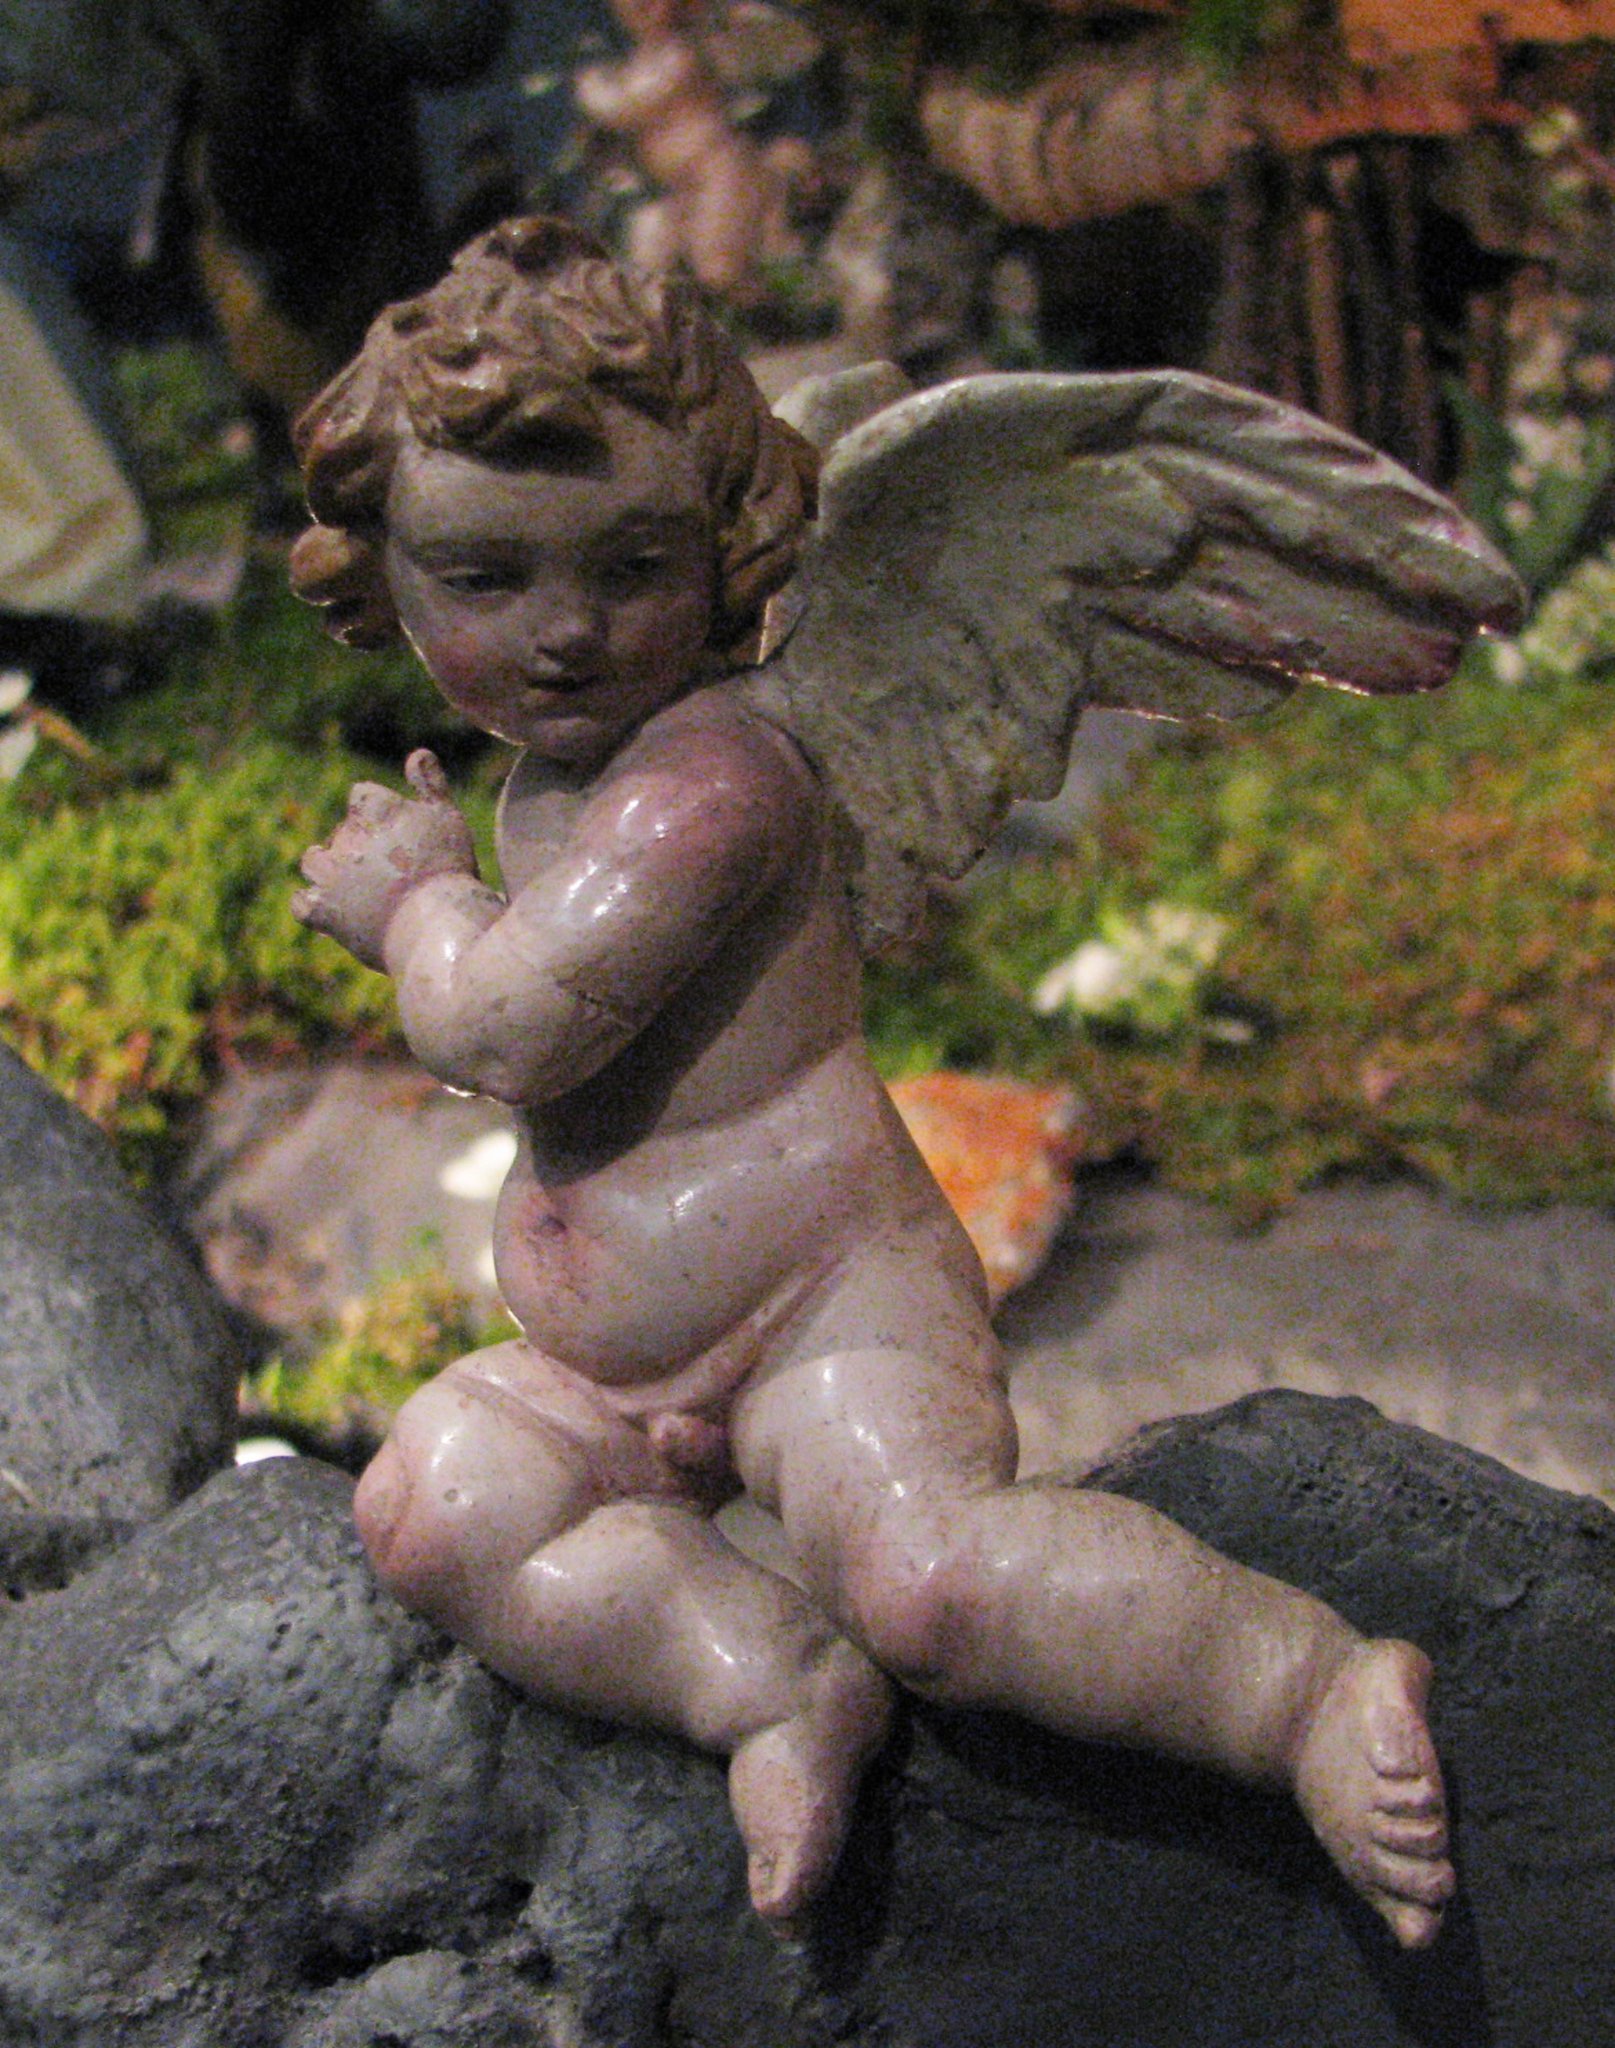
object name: crèche figure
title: Cherub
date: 1751-1800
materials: wood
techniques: polychrome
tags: angels